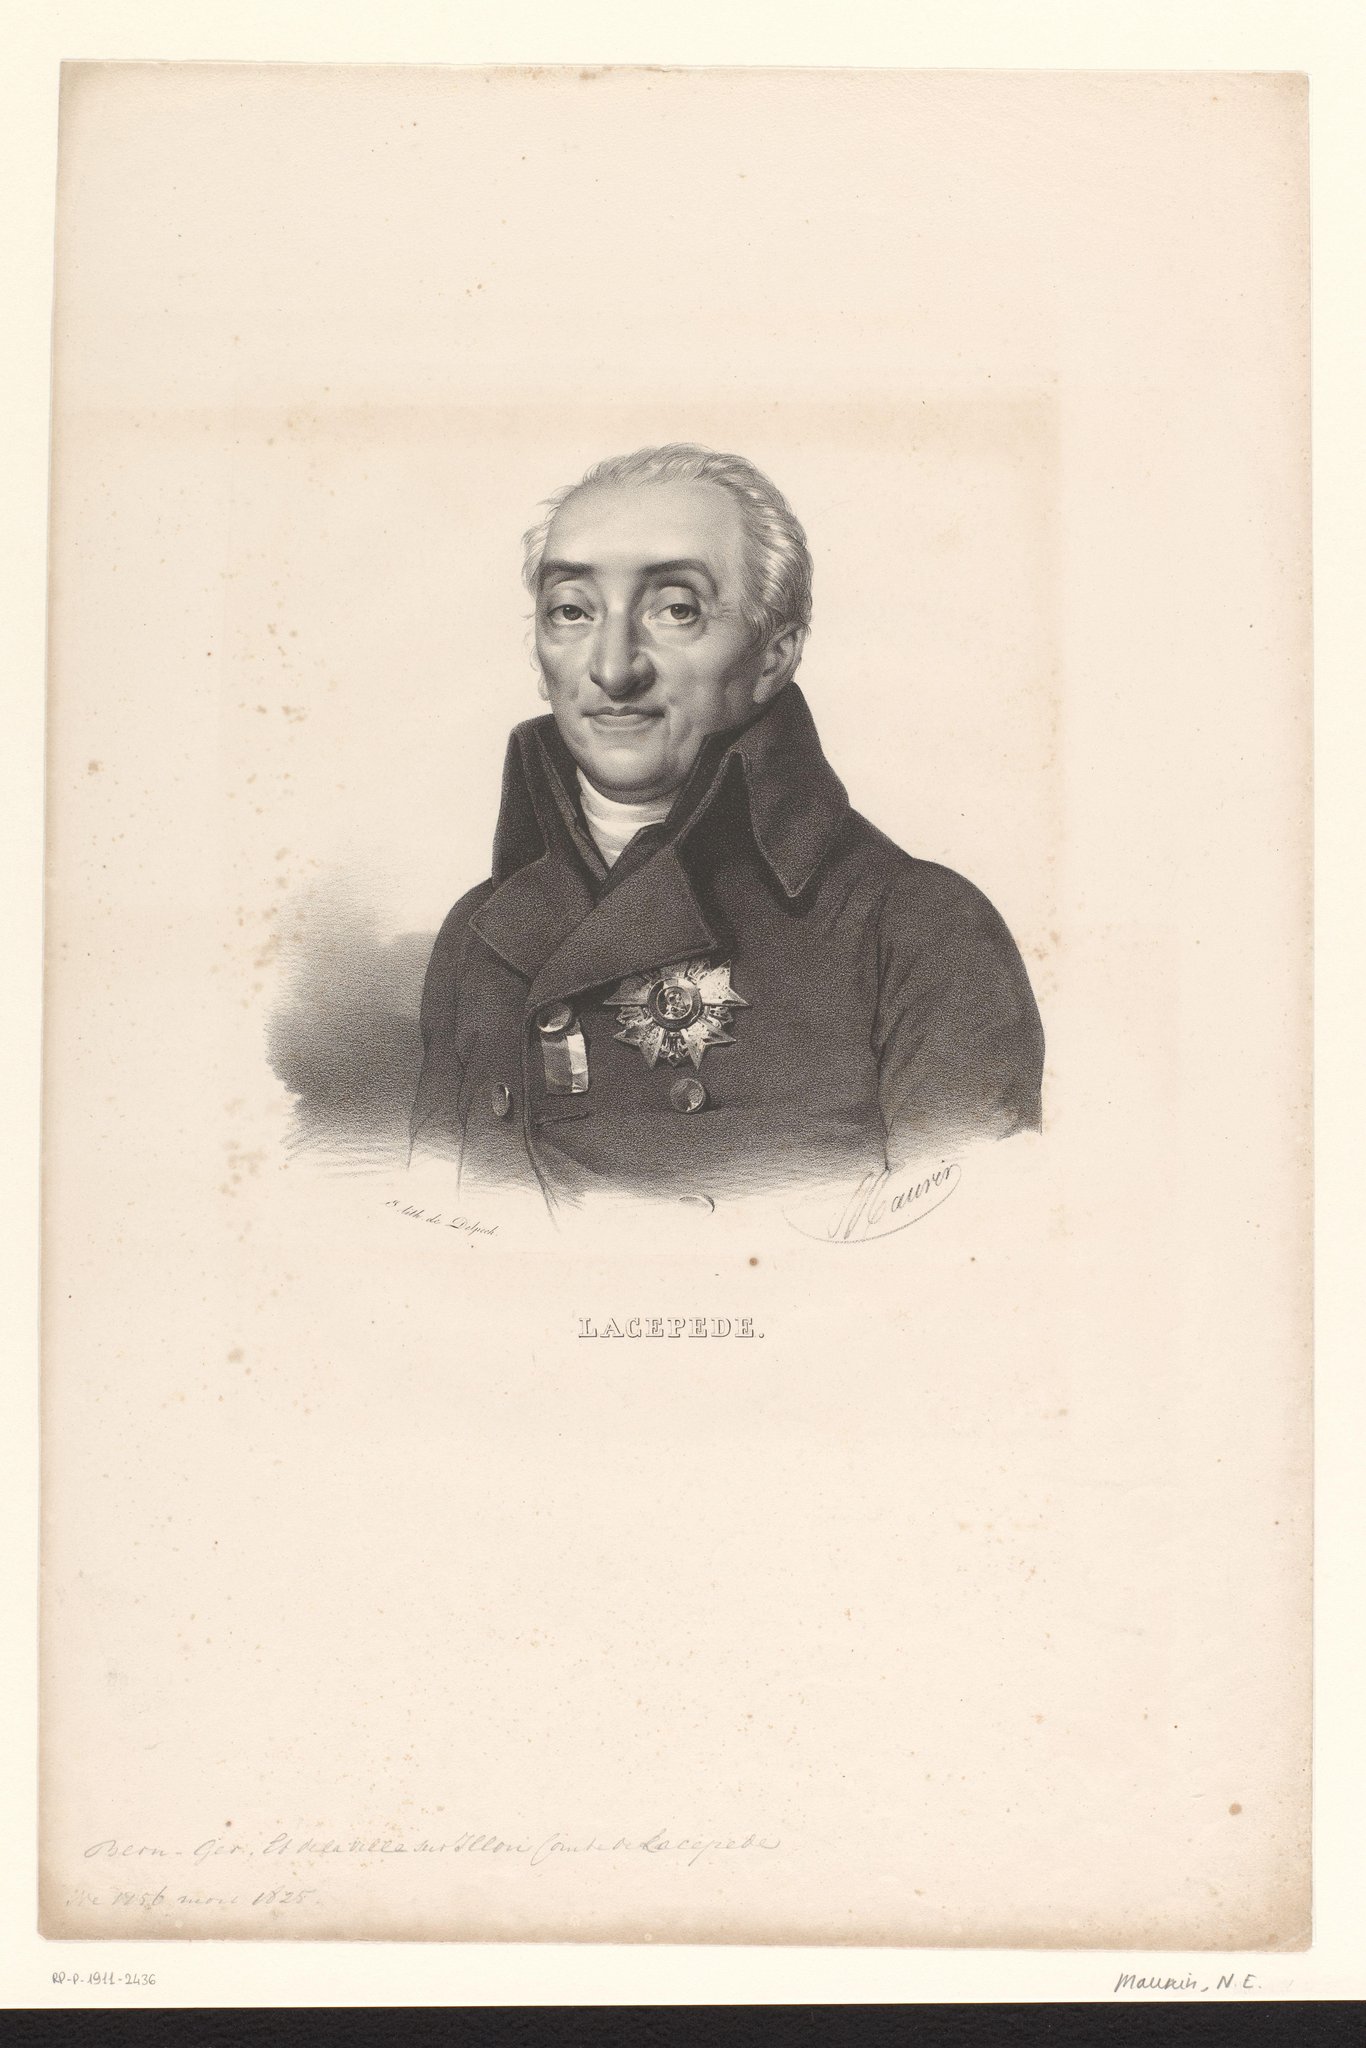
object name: print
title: Lacepede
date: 1825-1842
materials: paper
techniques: lithograph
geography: paris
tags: politician, historical persons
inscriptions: collector's mark: Lugt 2228